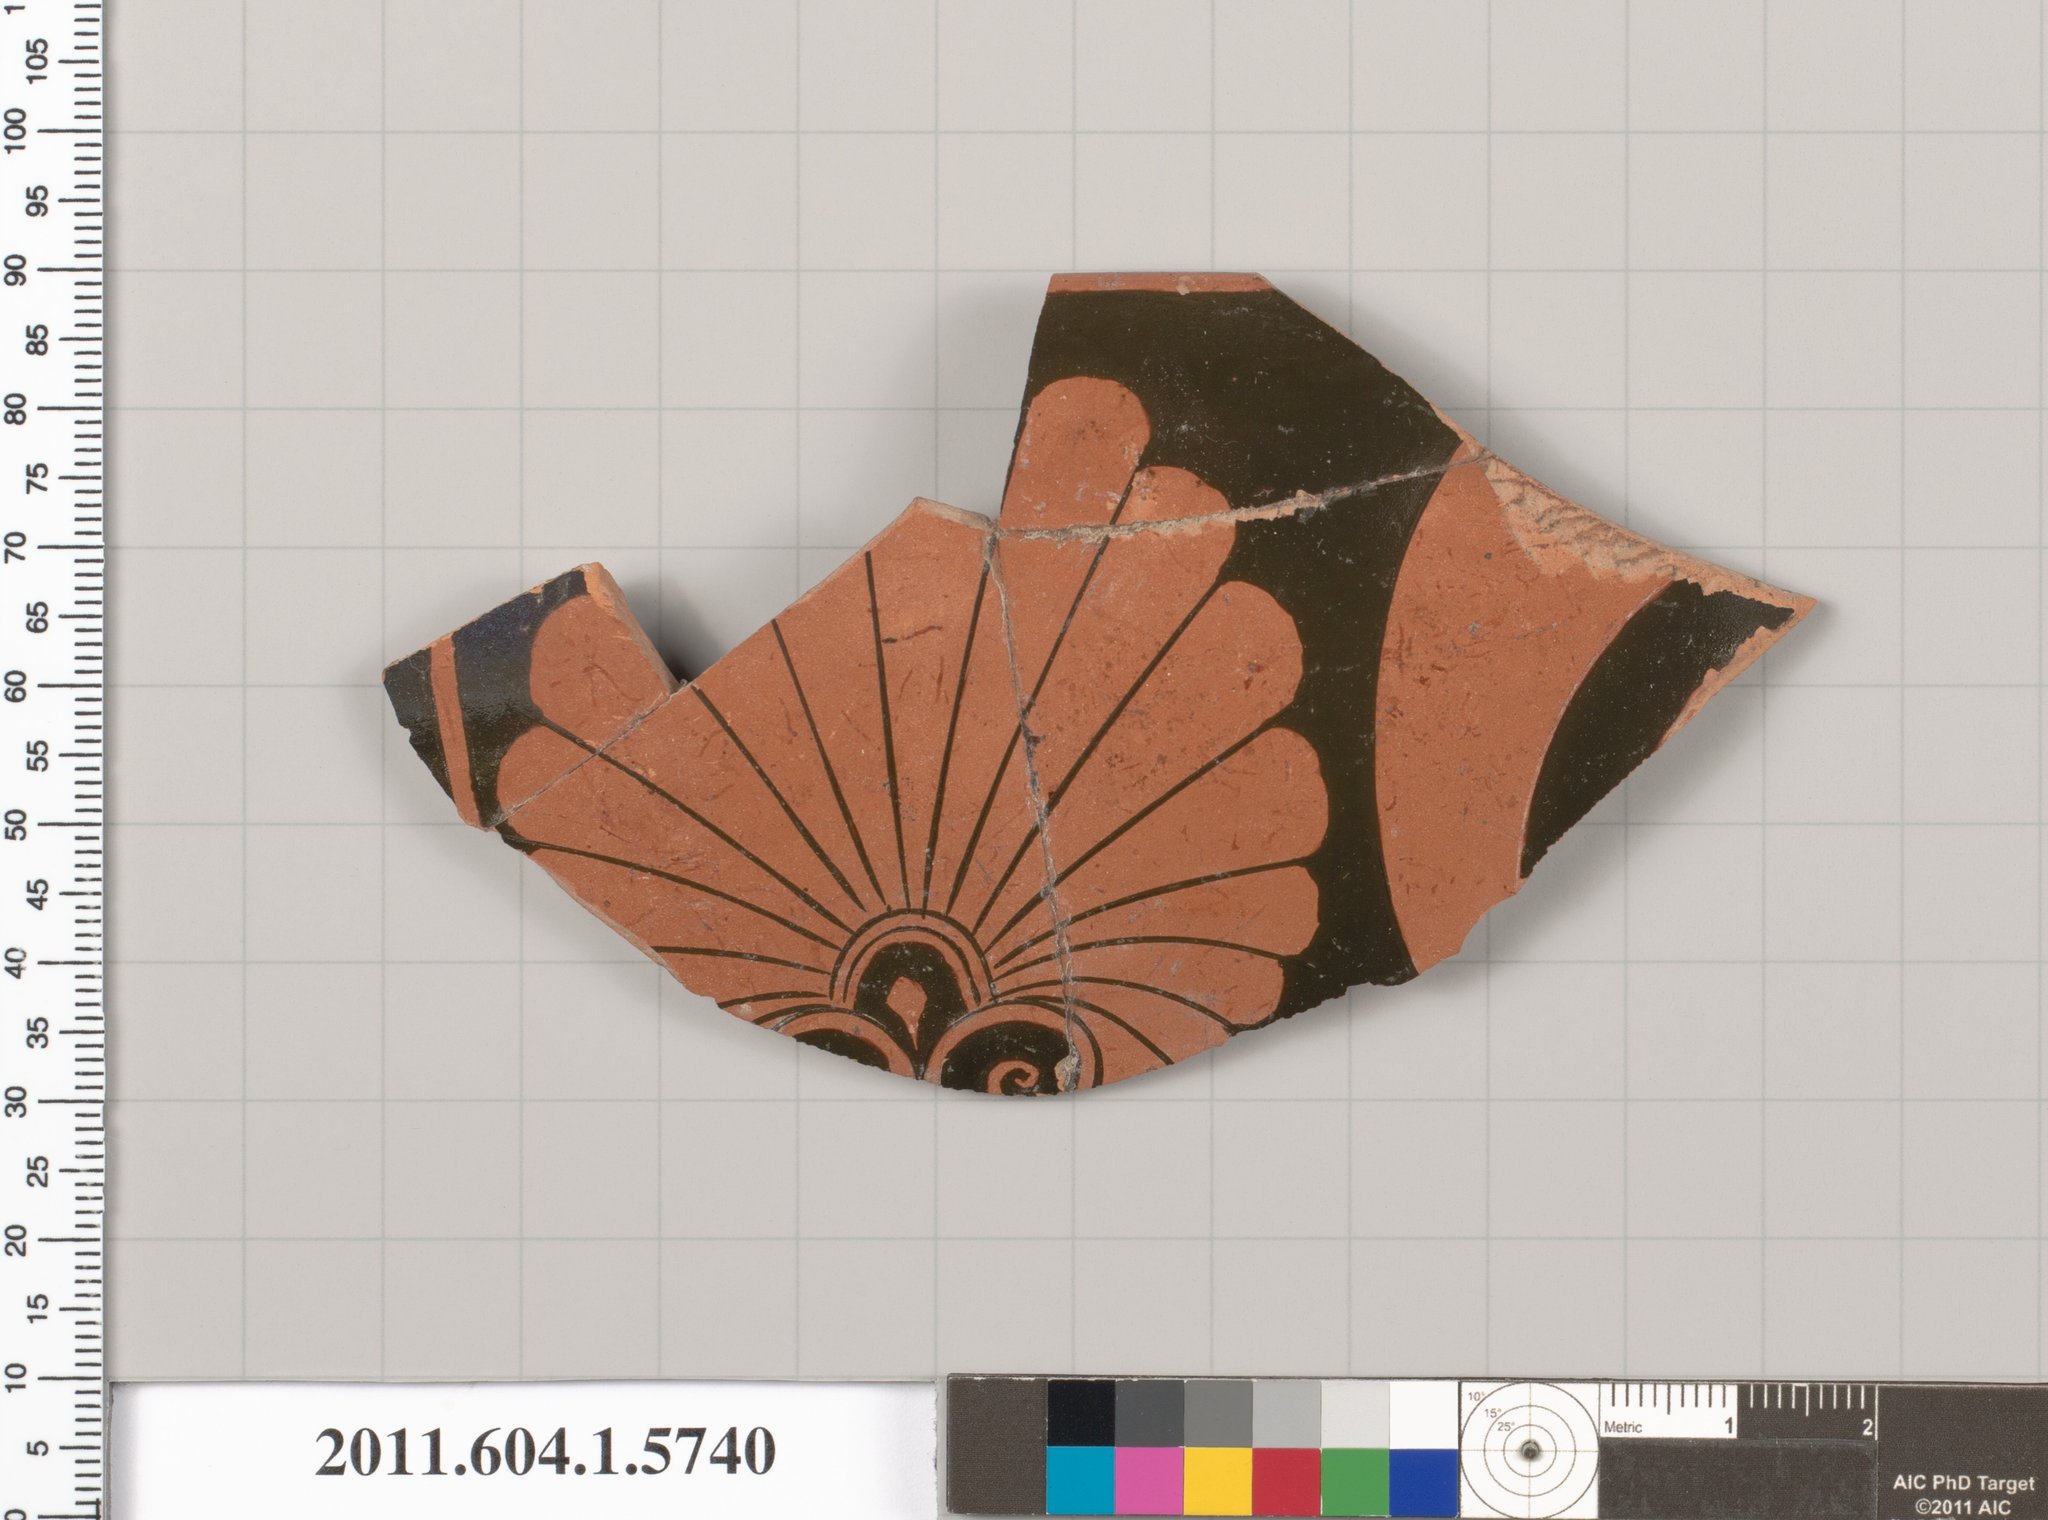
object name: kylix fragment, eye cup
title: Terracotta rim fragment of a kylix: eye-cup (drinking cup)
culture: greek, attic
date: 520-510 BCE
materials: terracotta